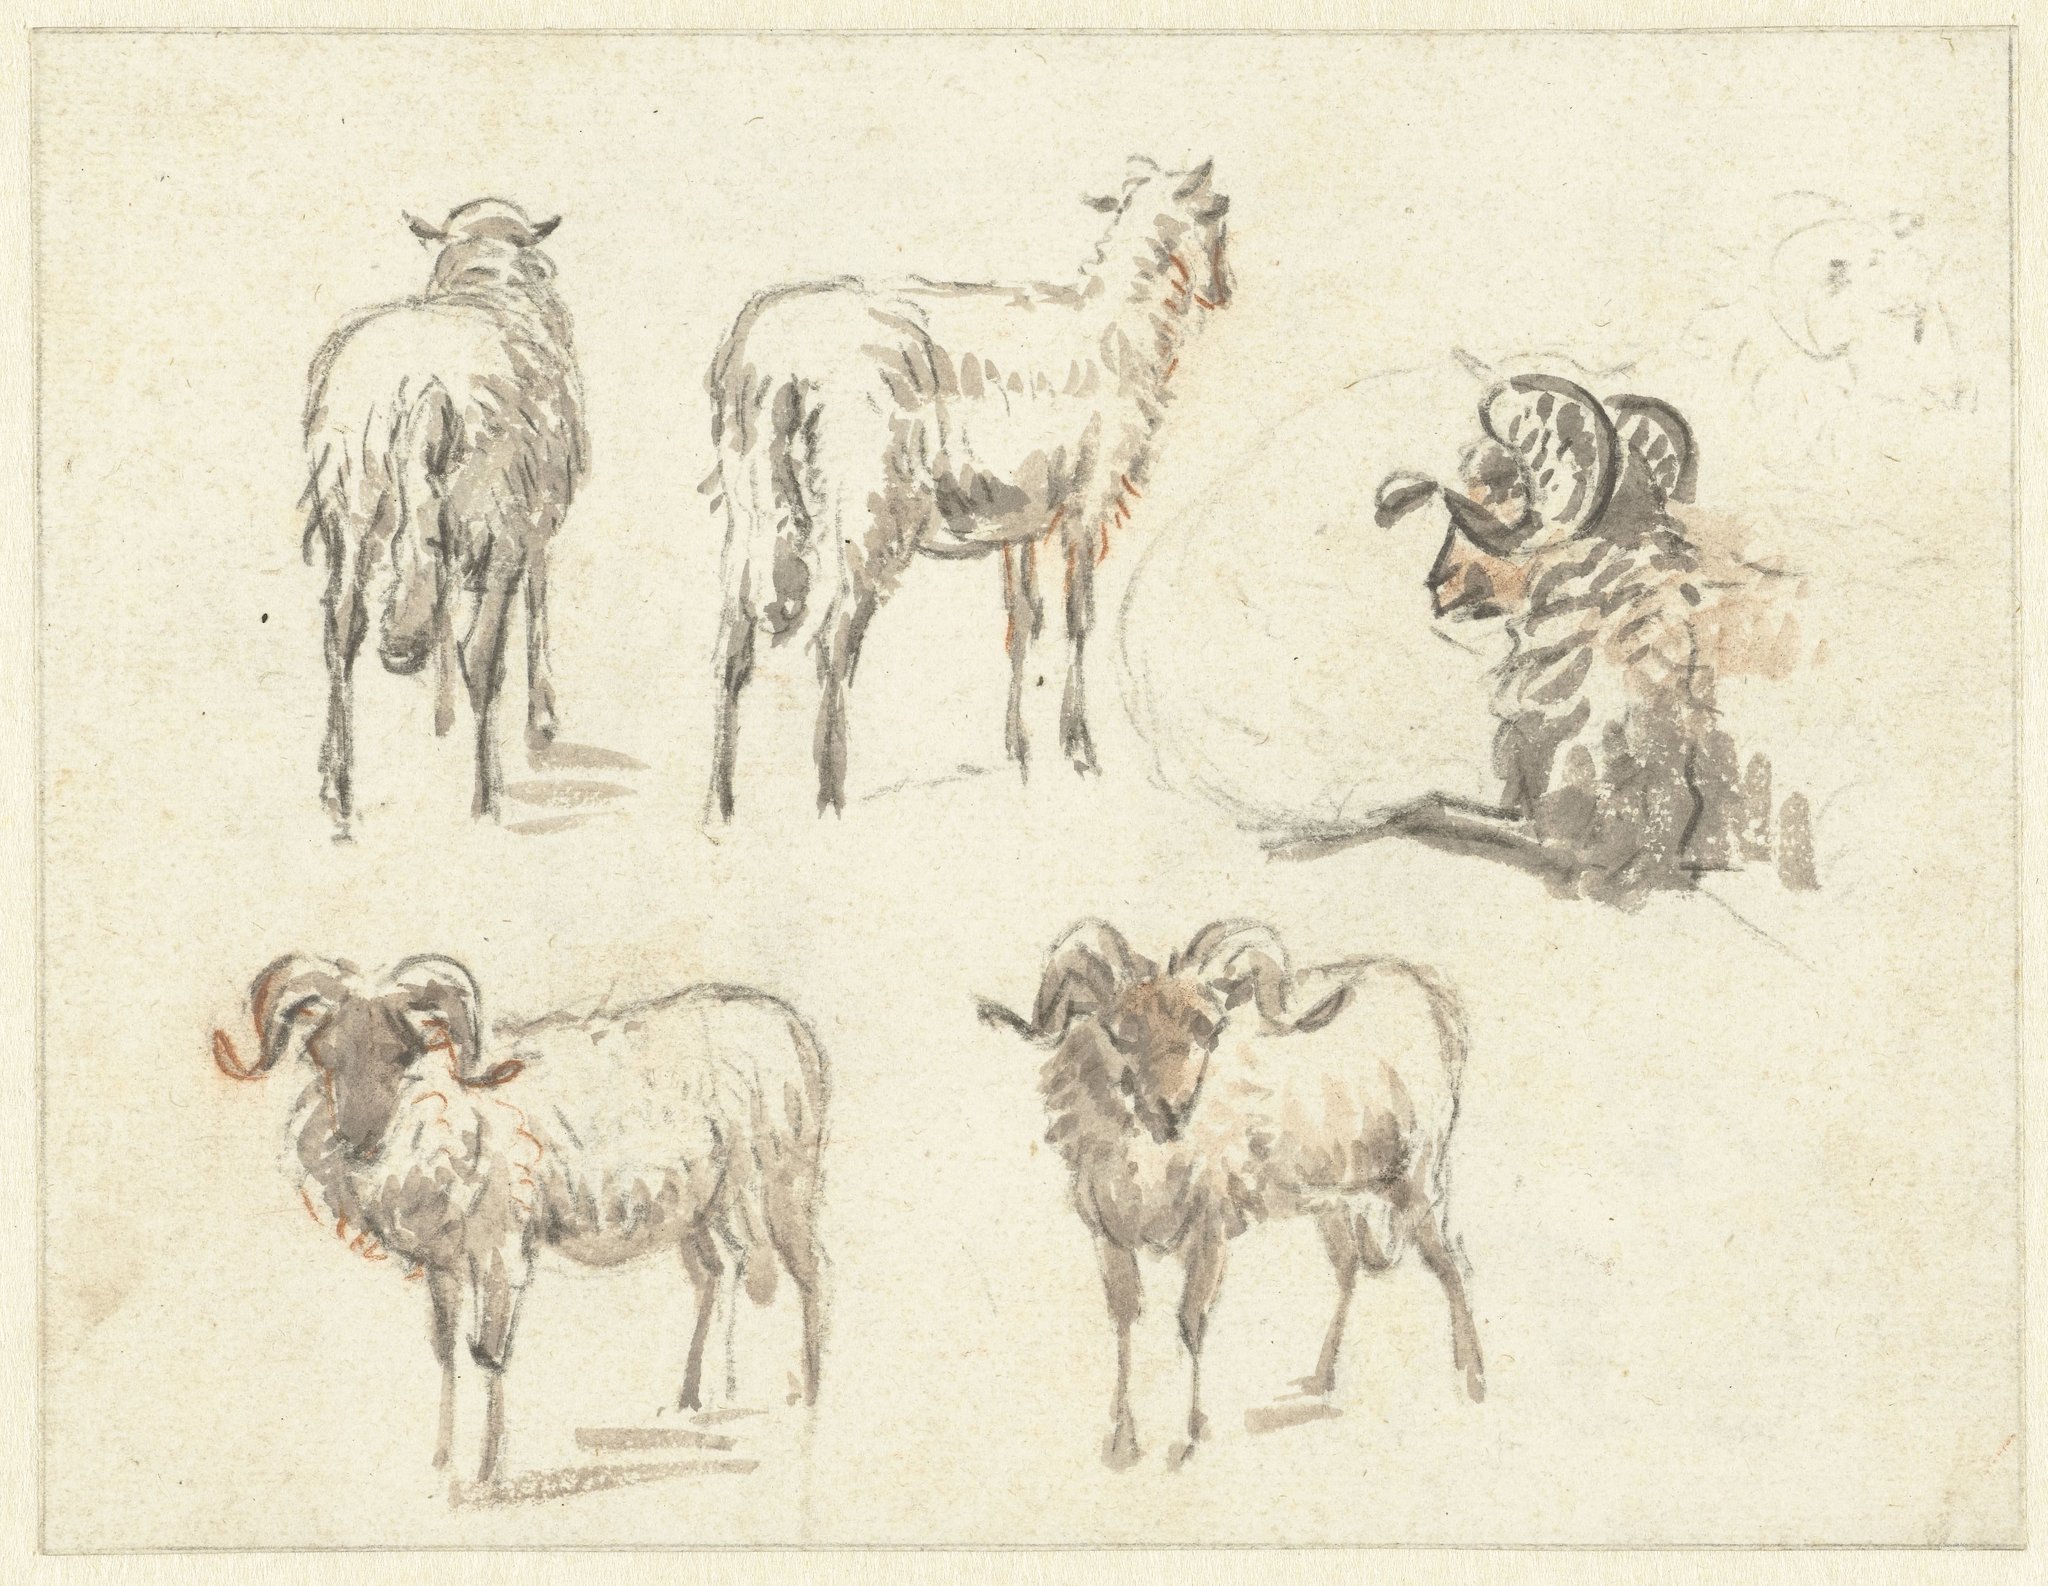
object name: drawing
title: Schetsblad met twee geiten en drie rammen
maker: pieter gerardus van os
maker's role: draughtsman, painter, print maker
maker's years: 1776-1839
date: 1786-1839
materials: chalk, paper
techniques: brush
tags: sheep, goat